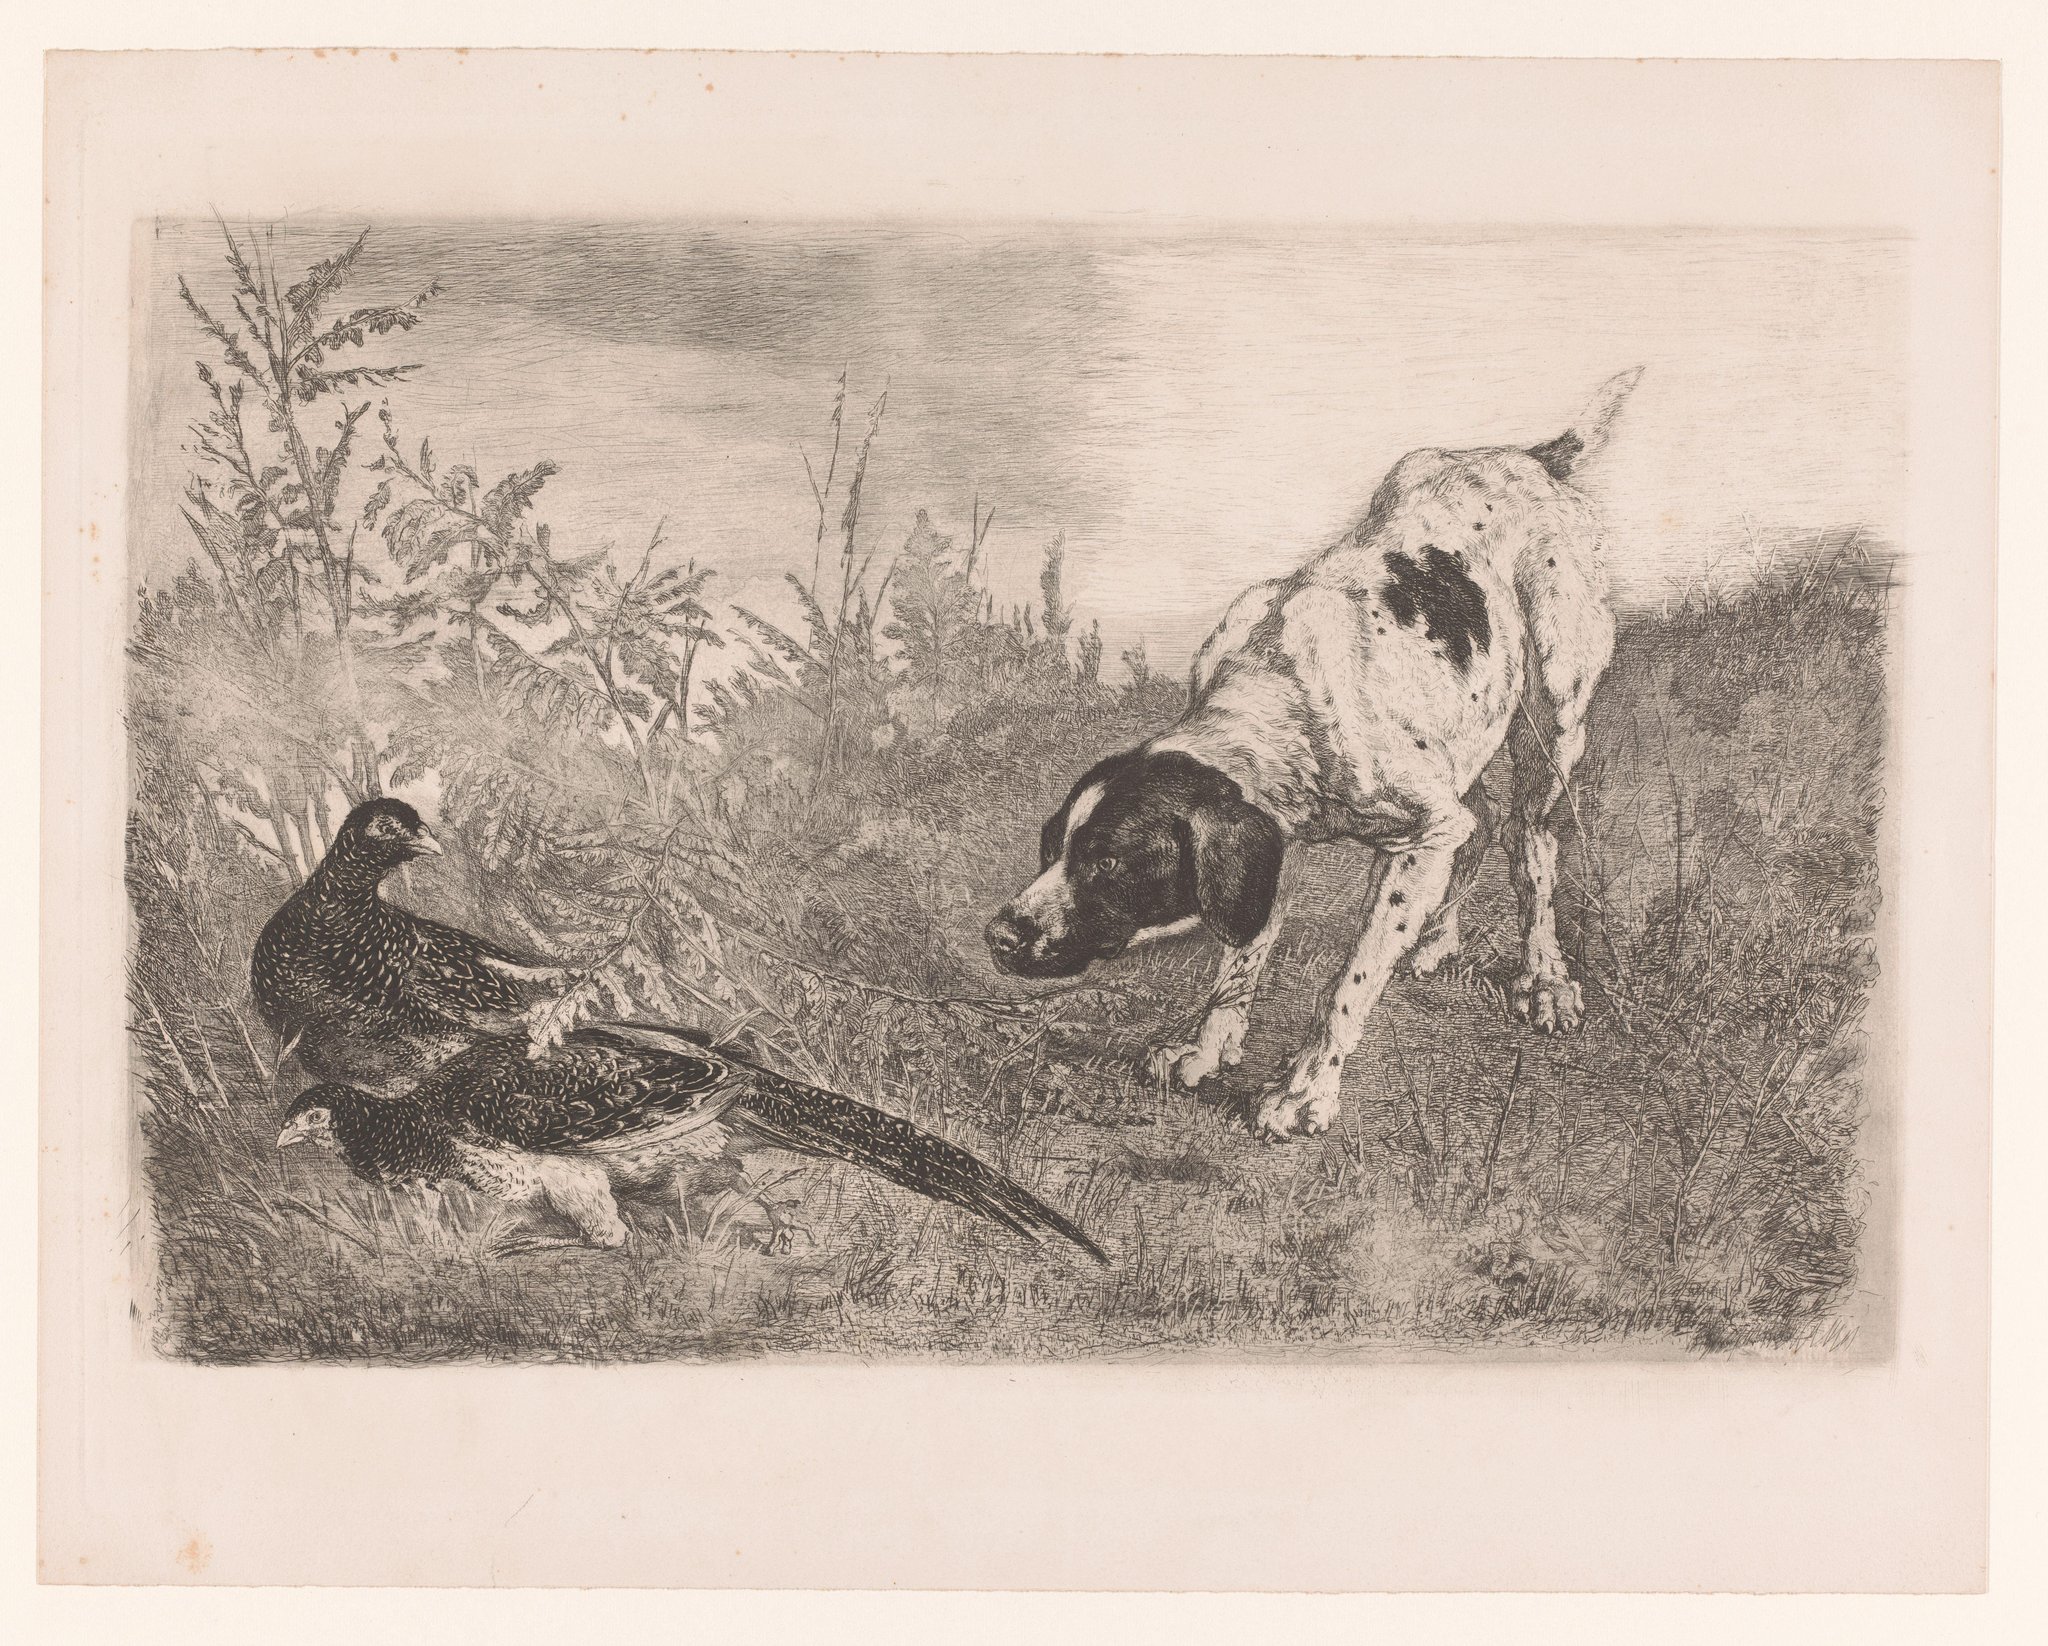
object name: print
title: Jacht op fazanten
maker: charles verlat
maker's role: painter, print maker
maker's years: 1824-1890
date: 1882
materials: paper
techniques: drypoint, etching, intaglio, retroussage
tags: hunting dogs, walker and runner birds: pheasant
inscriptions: collector's mark: Lugt 2228